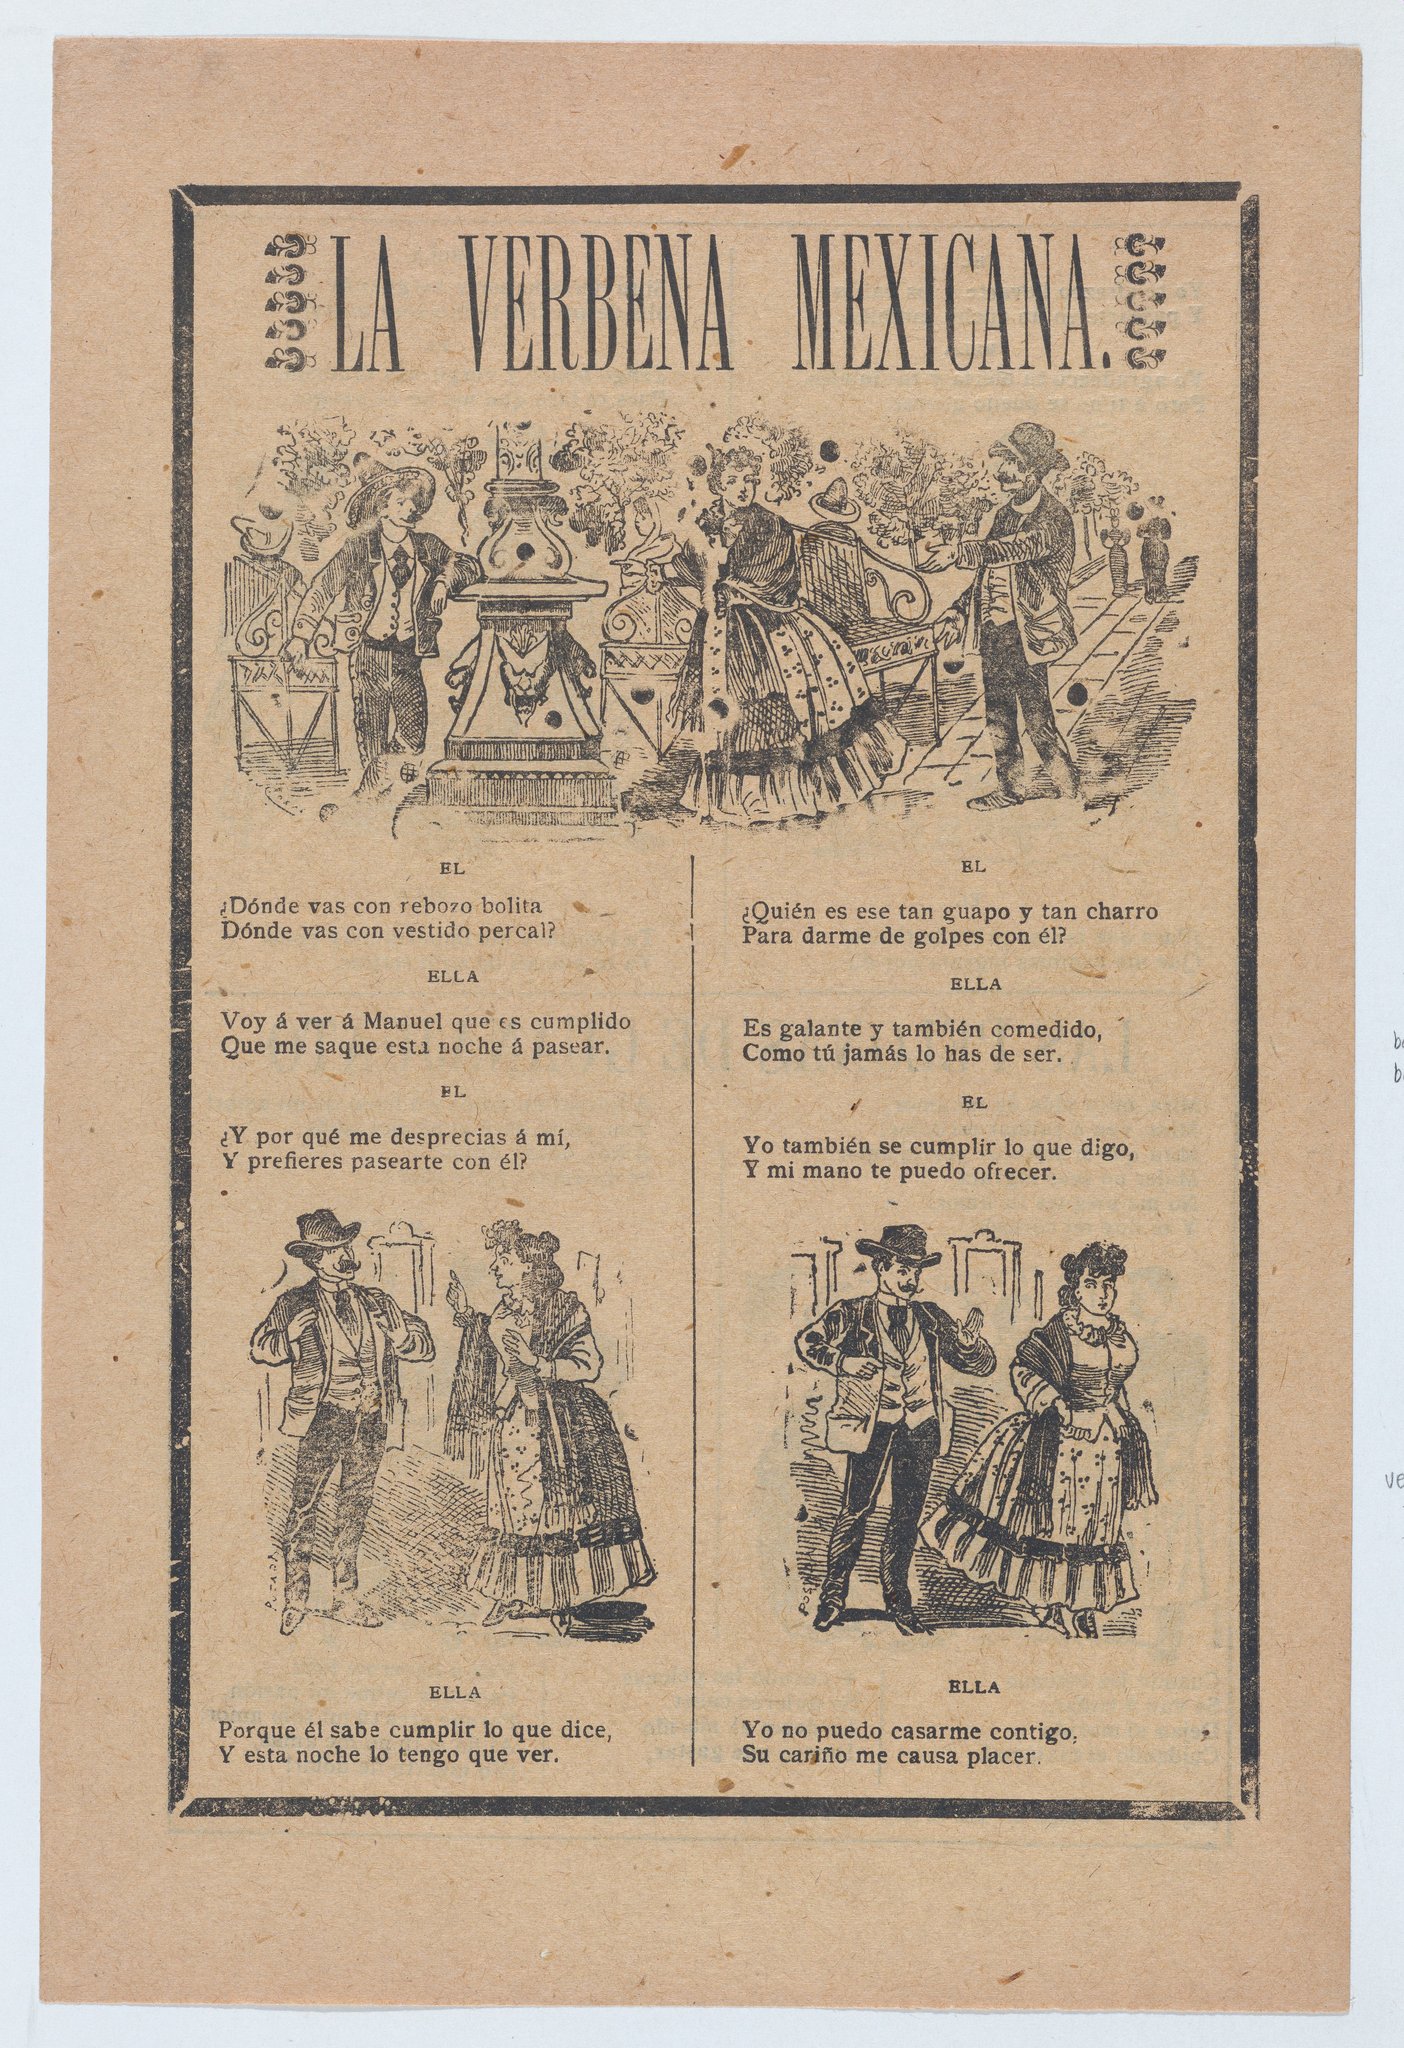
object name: print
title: Broadsheet with a verse about a woman who rejects a male suitor for another, vignettes of a woman talking to various men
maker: josé guadalupe posada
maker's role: artist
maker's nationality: mexican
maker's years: 1852-1913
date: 1900-1913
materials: paper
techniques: letterpress, lithography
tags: men,women